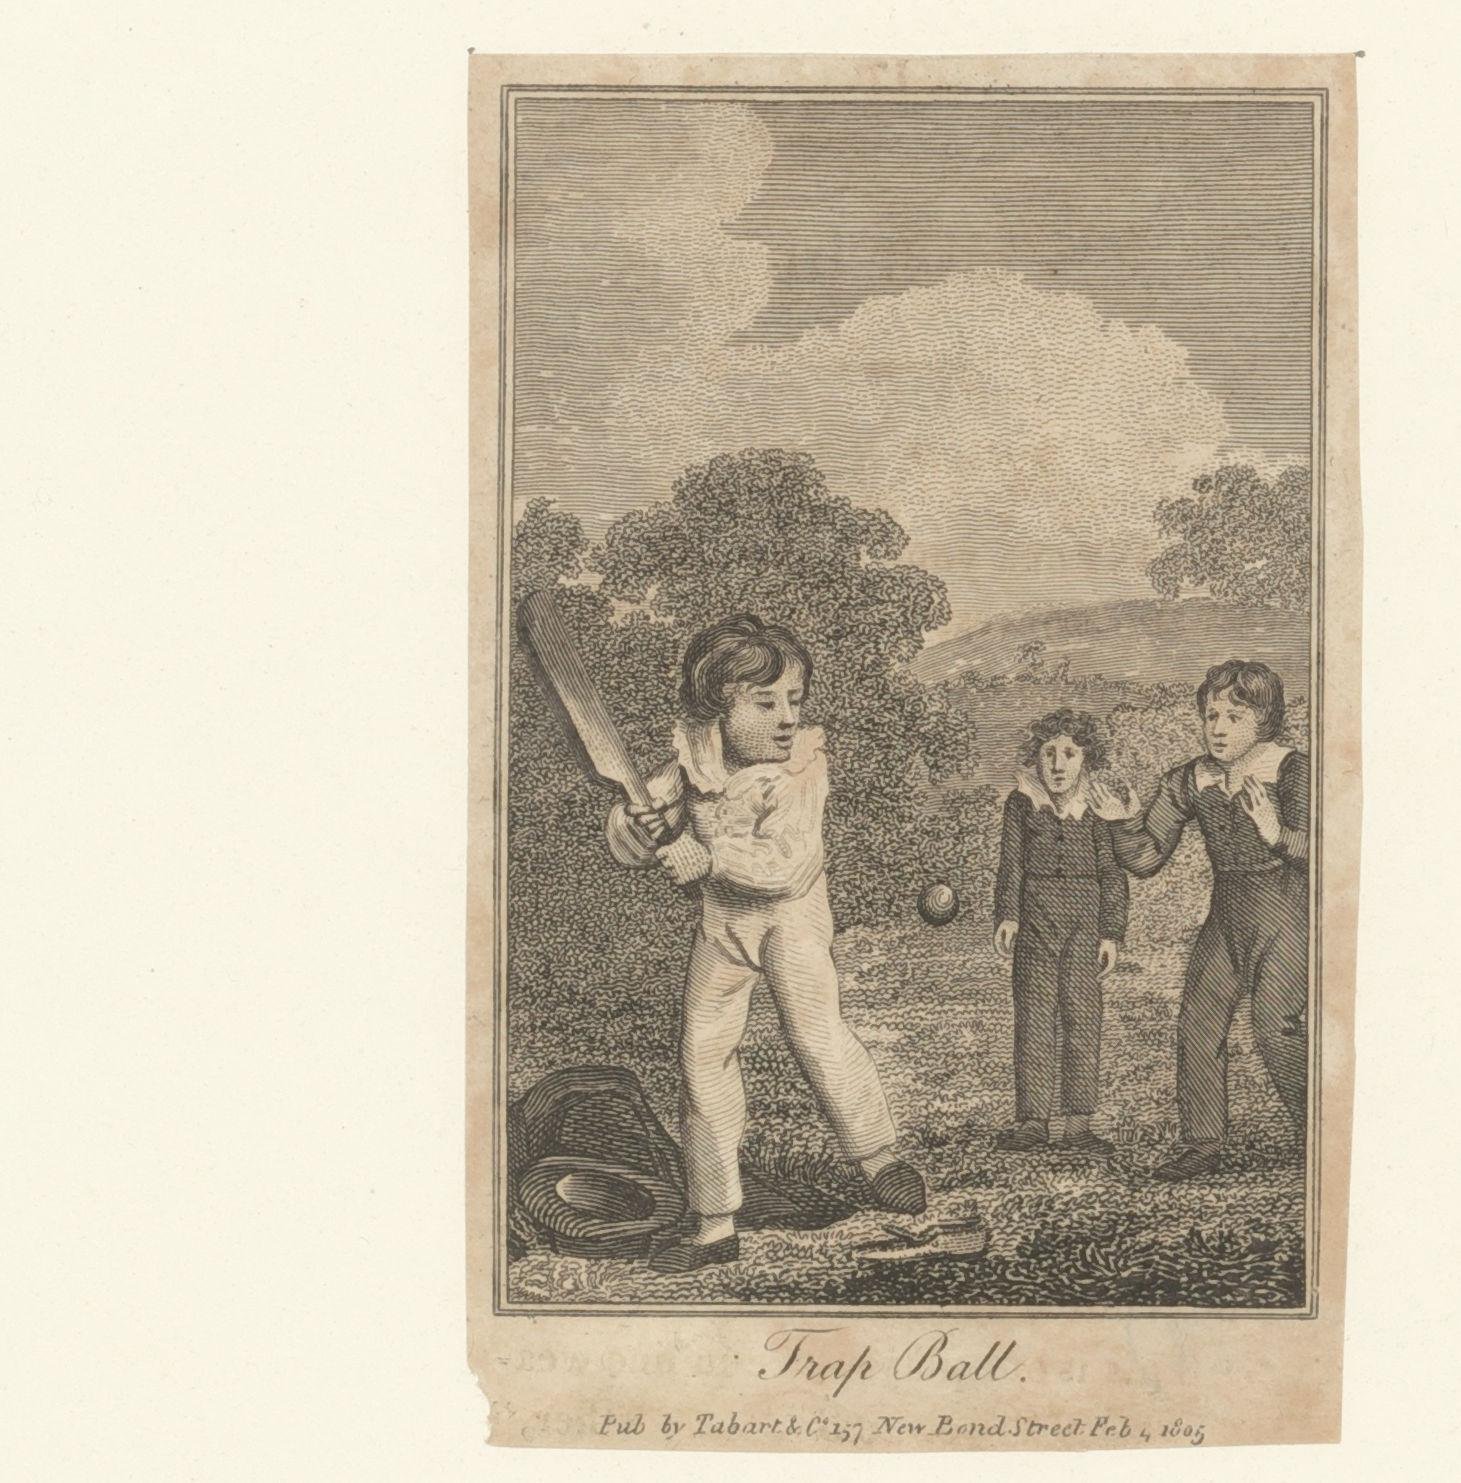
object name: print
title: Trap Ball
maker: Anonymous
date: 1812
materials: paper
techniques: engraving, etching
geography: london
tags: children's games and plays, ball games in which ball is hit with wooden object (team play) (+ out of doors (sports, games, etc.))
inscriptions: stamp, collector's mark: Lugt 1641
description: Onderwerpsrubrieken binnen de Atlas Zeden en Gewoonten: Zeden en Gewoonten in Engeren Zin, Des menschen beging, midden en einde, Kinderleven – Kinderspel en Kinderprenten.